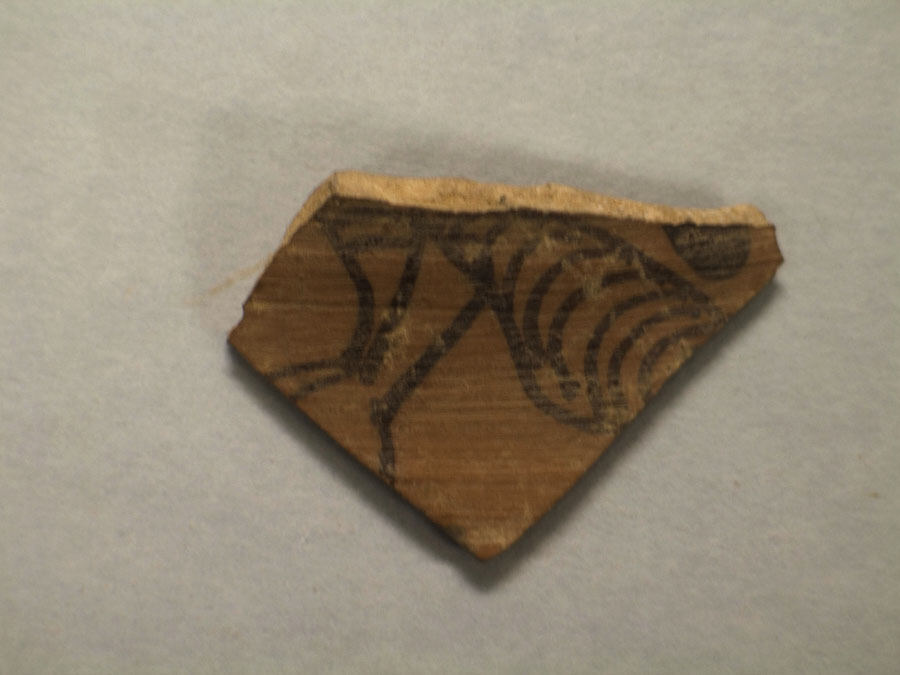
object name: shard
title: Shard: Face of Offerer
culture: pakistani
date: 301-500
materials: terracotta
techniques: painting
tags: gandhara